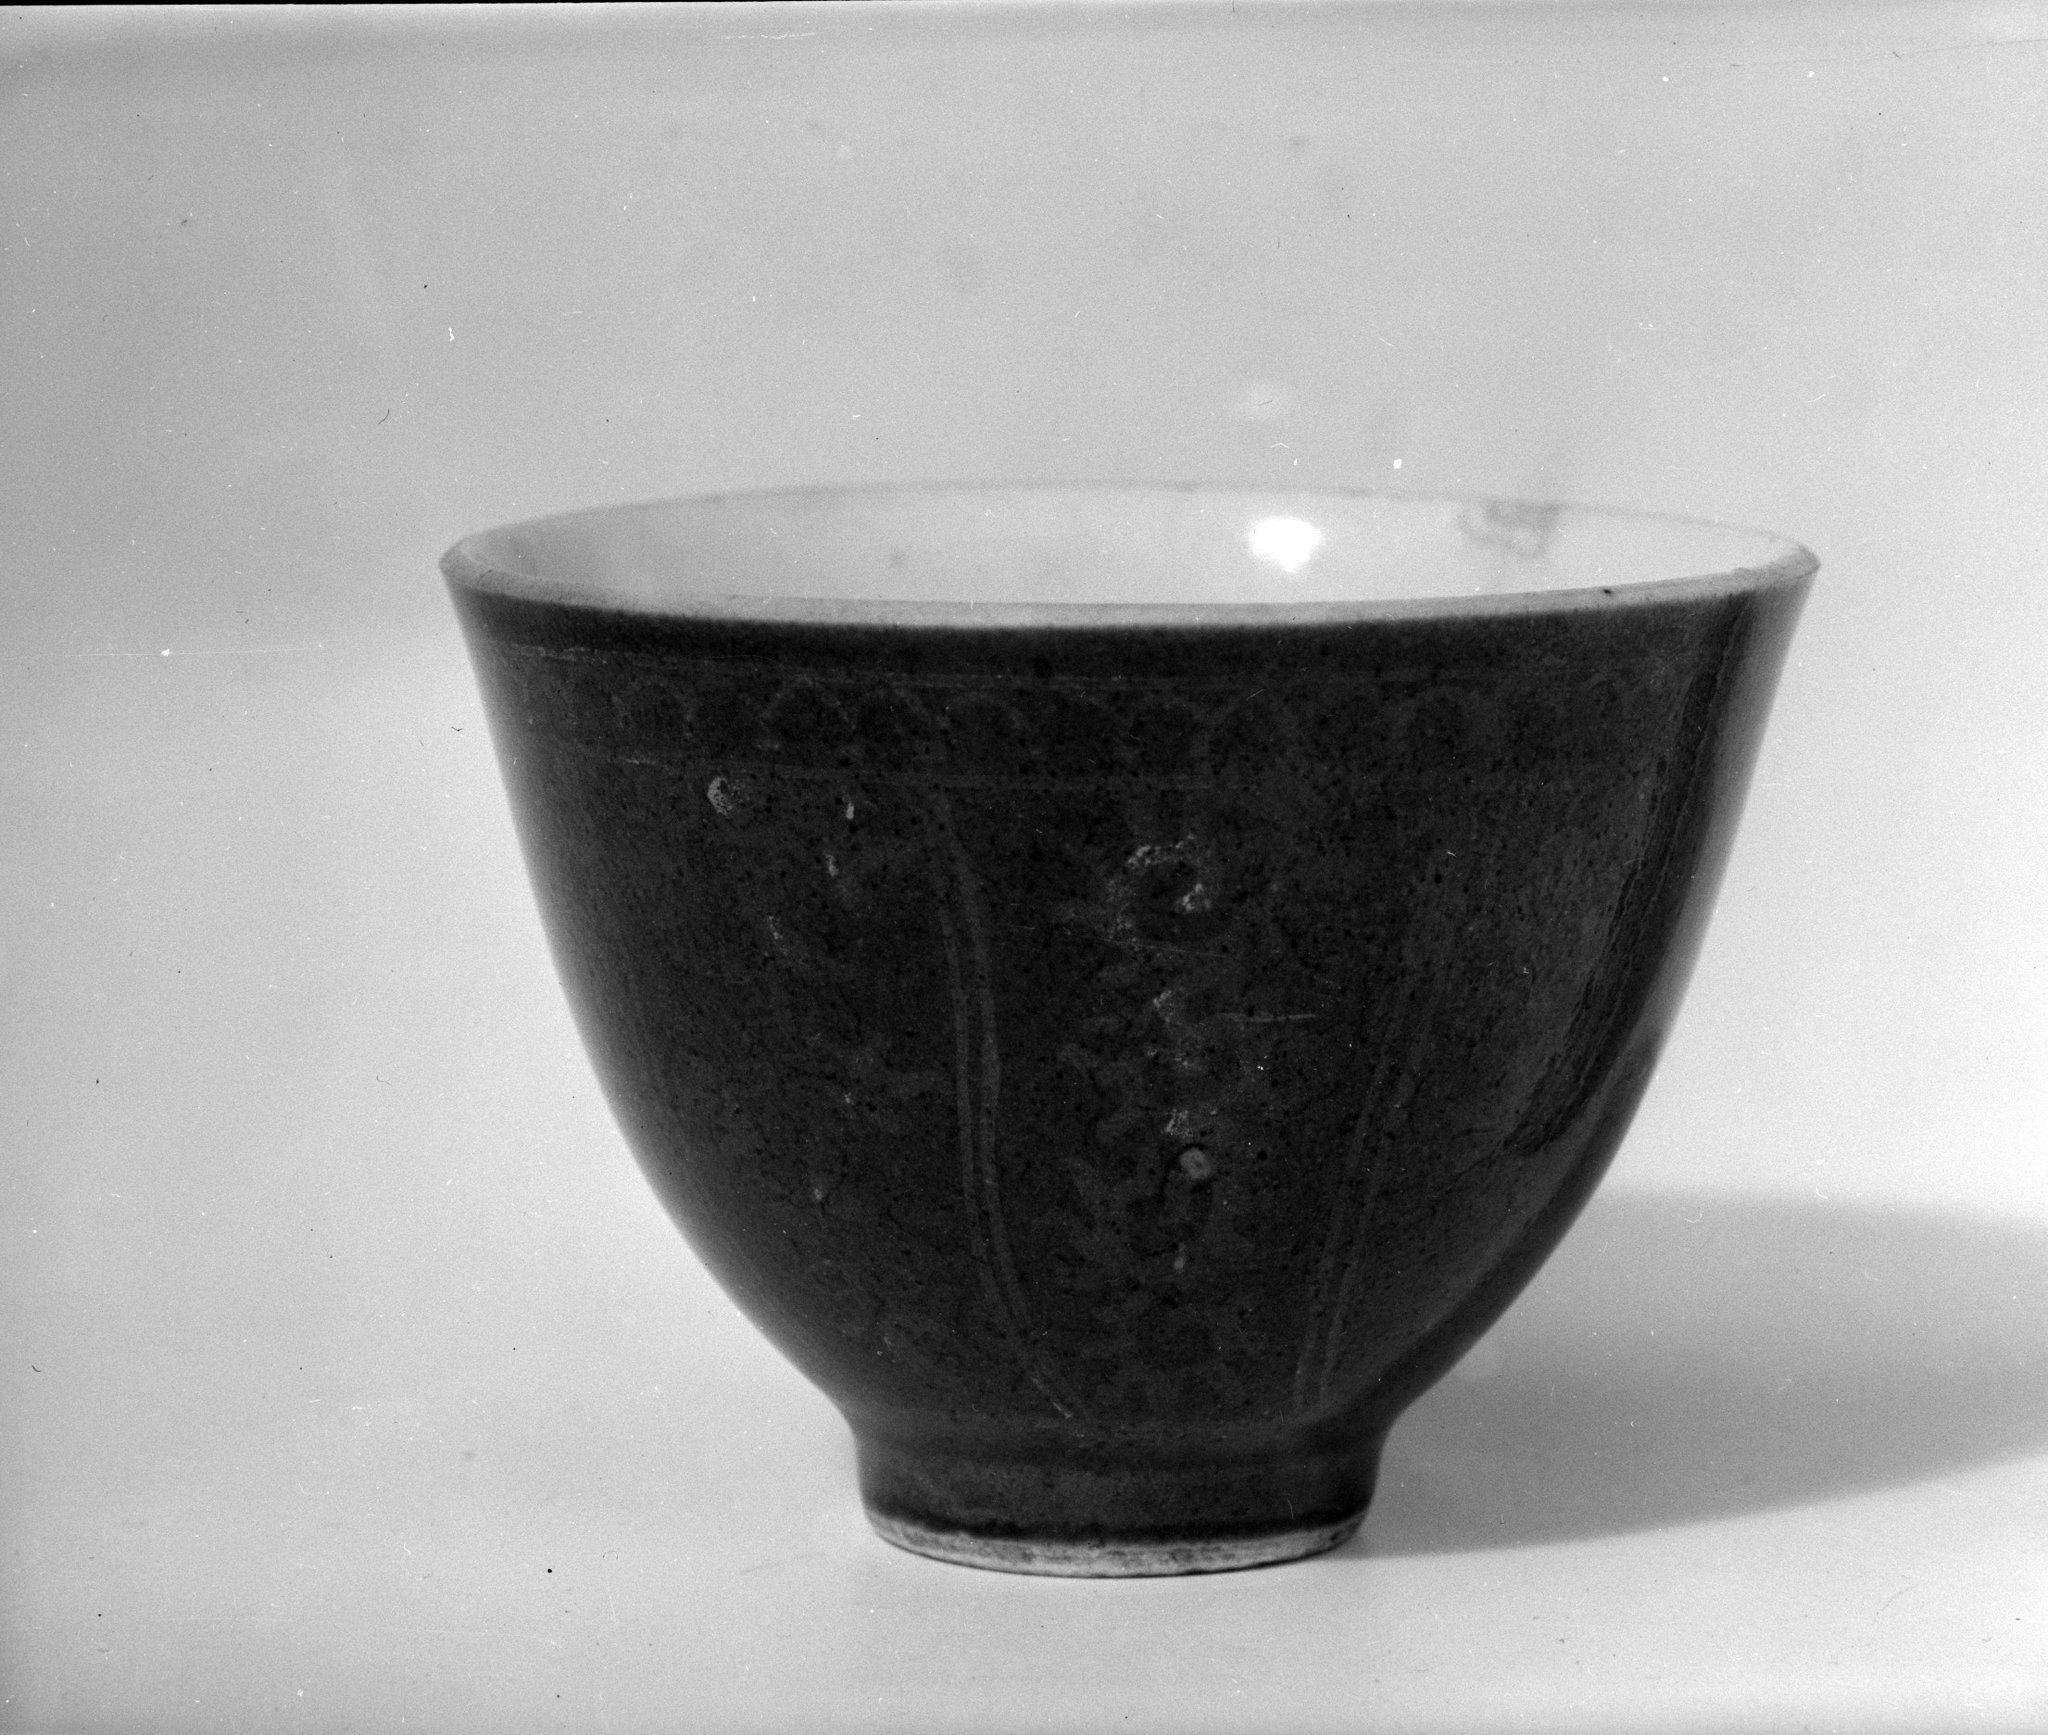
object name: cup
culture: chinese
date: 1736-1795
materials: porcelain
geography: china